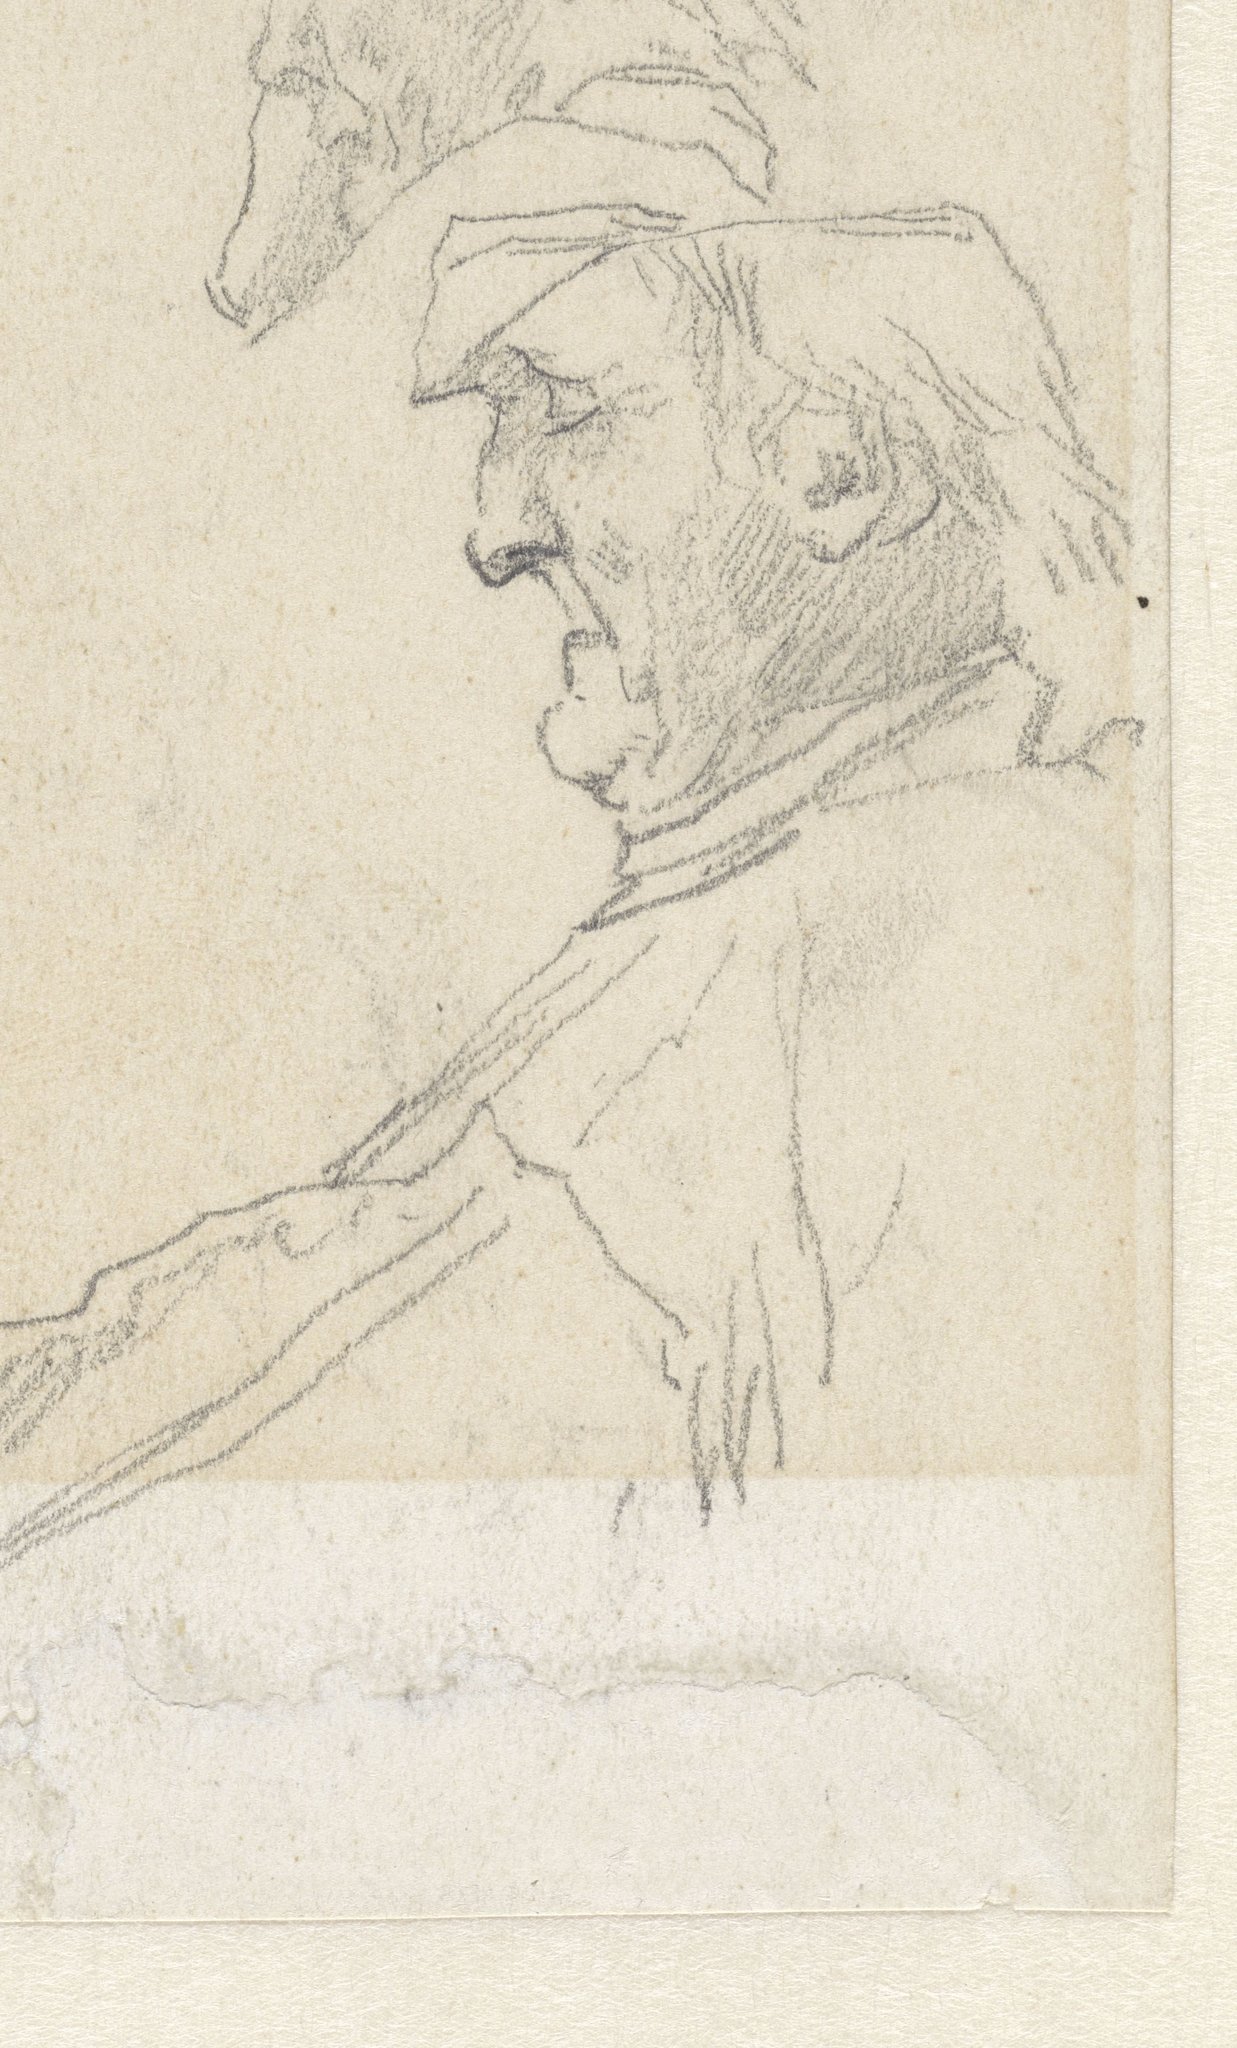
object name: drawing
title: Twee schetsen van mansprofielen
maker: jacob maris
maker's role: draughtsman, painter, print maker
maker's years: 1837-1899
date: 1847-1899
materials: paper, pencil